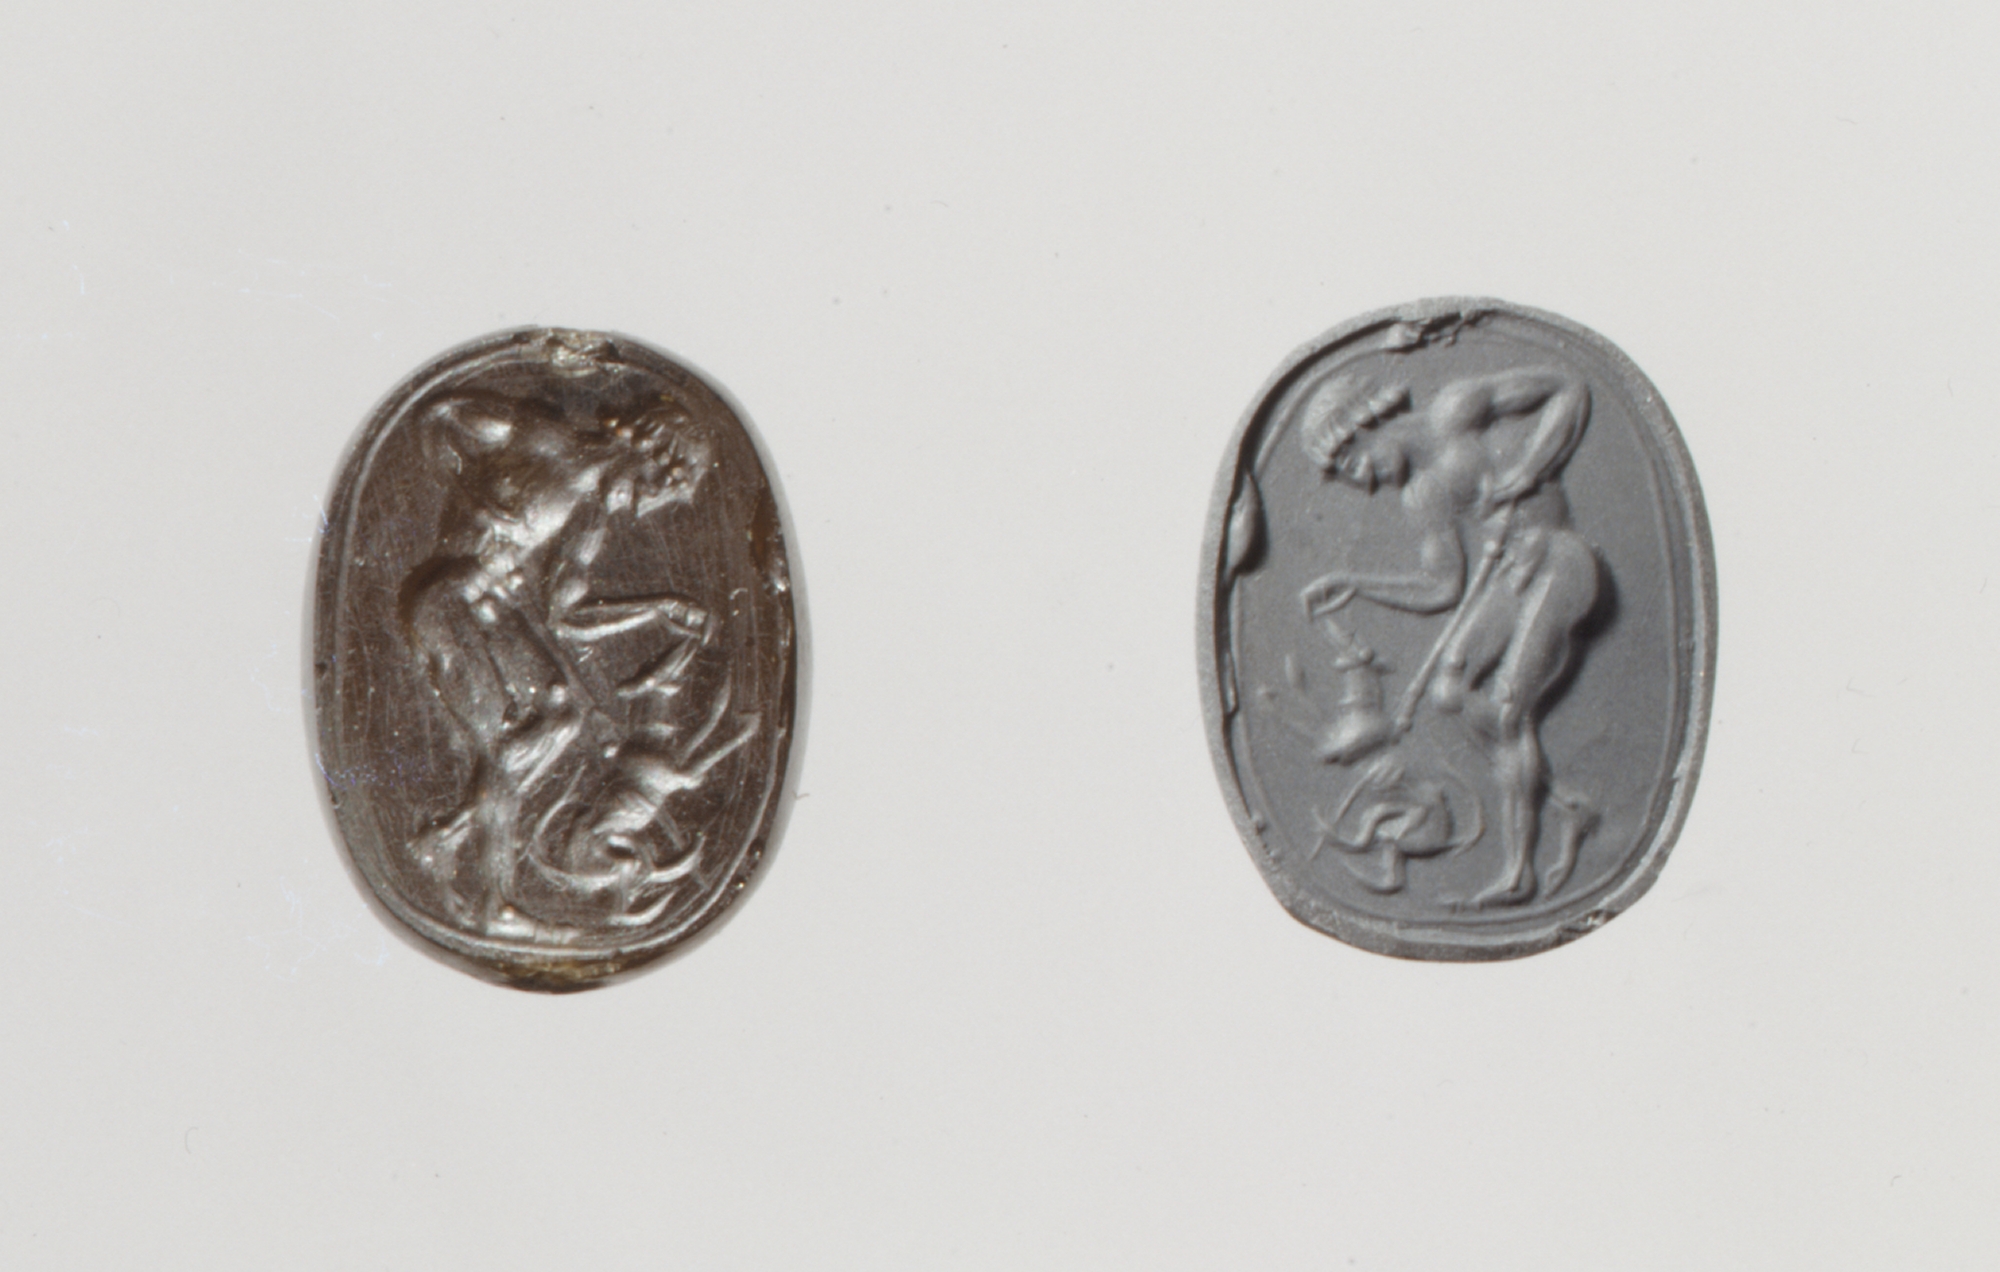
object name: scaraboid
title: Chalcedony scaraboid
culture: greek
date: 500 BCE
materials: stone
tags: boys,dogs